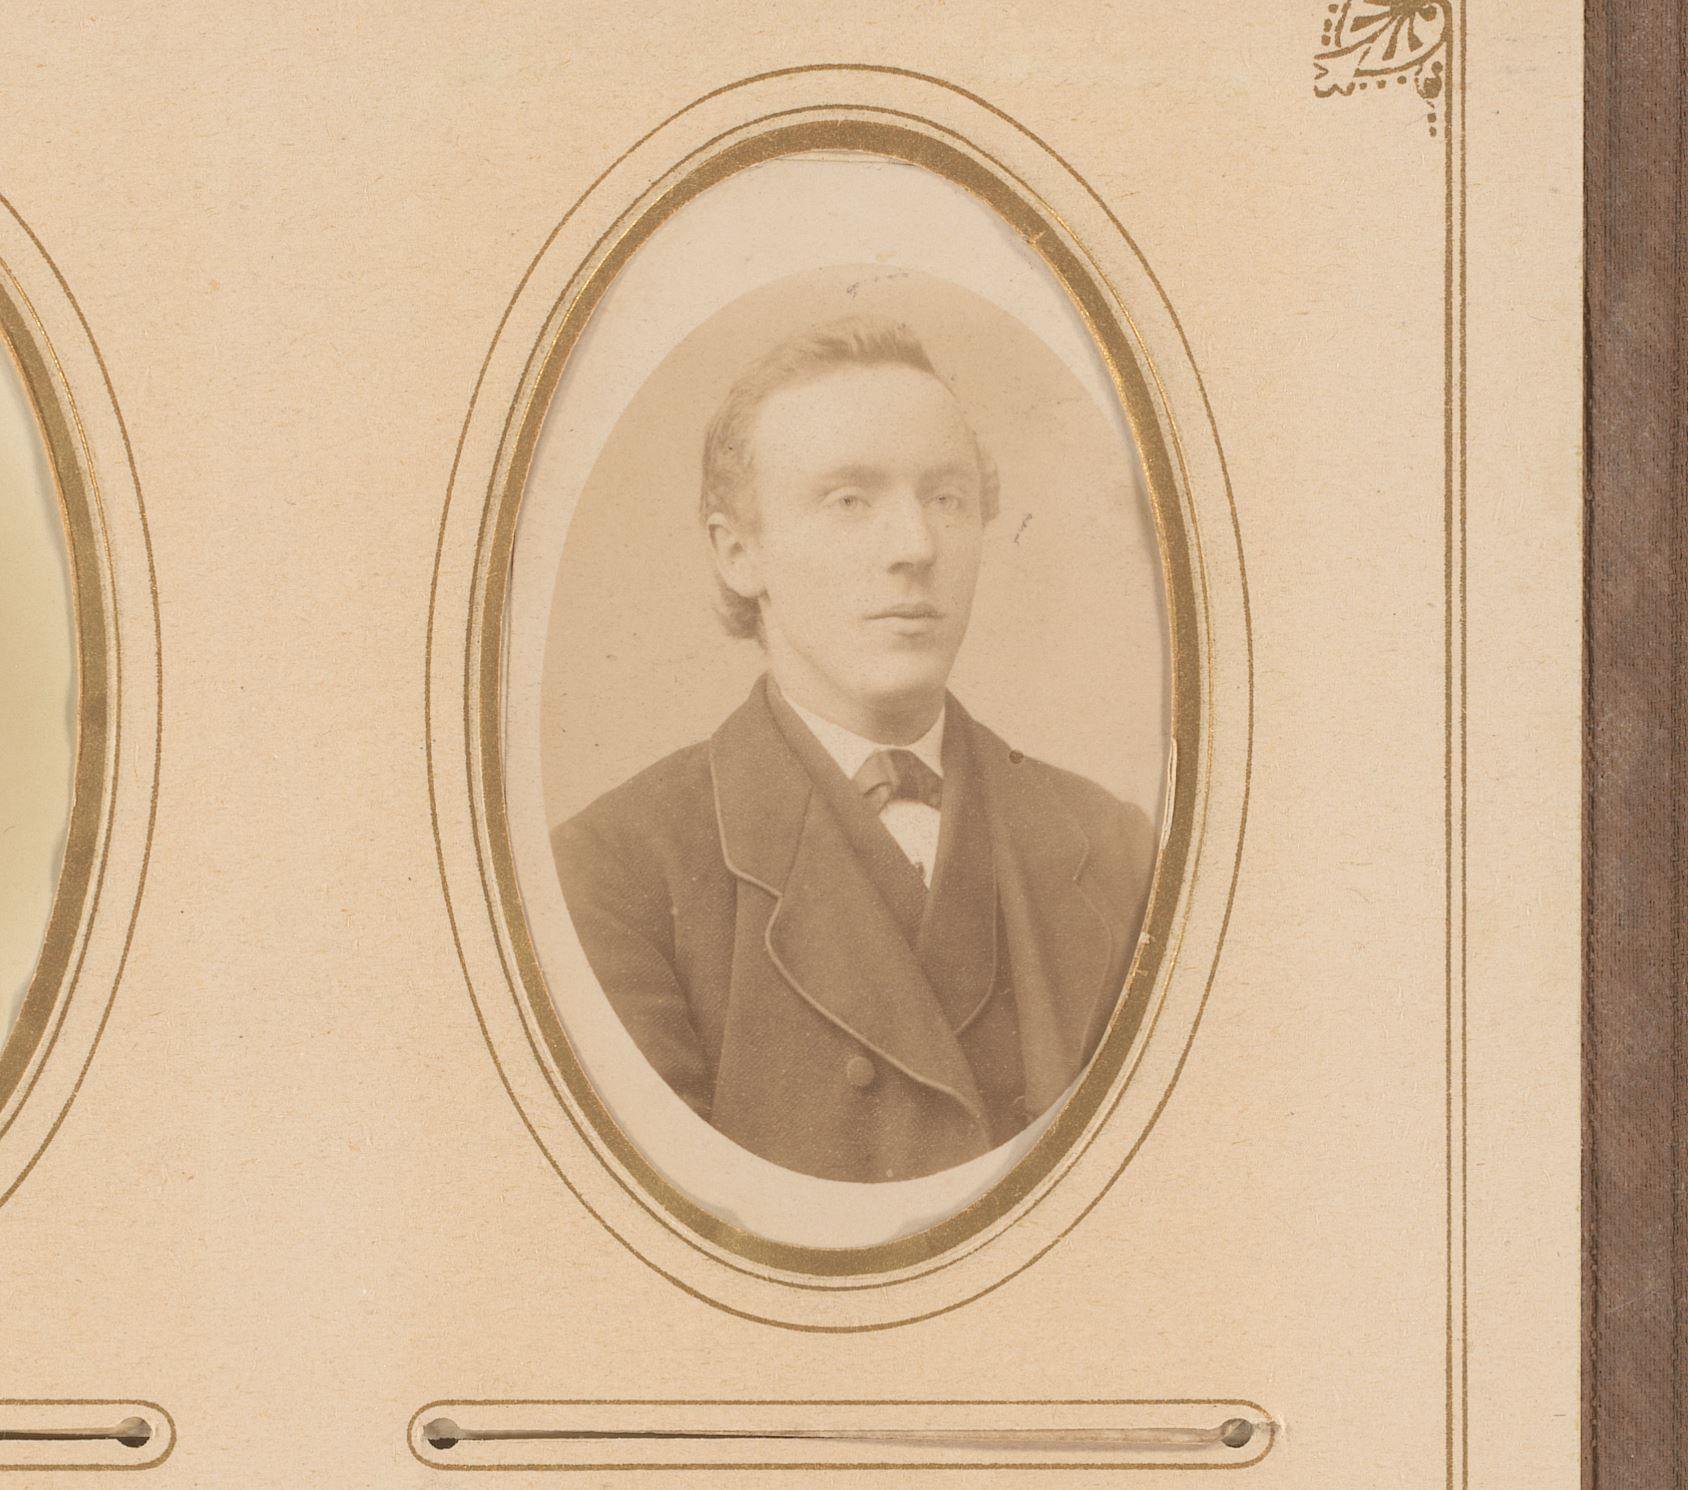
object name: carte de visite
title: Portret van een jonge man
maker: nicolaas johannes rinner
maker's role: fotograaf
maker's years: 1859-1931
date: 1882-1885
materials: cardboard, photographic support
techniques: albumen print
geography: purmerend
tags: historical persons, youth, adolescent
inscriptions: inscription: ‘Photographie Instantanée/ N. J. RINNER/ Speciale inrichting voor portretvergrootingen/ Purmerend./ Kerkstraat’